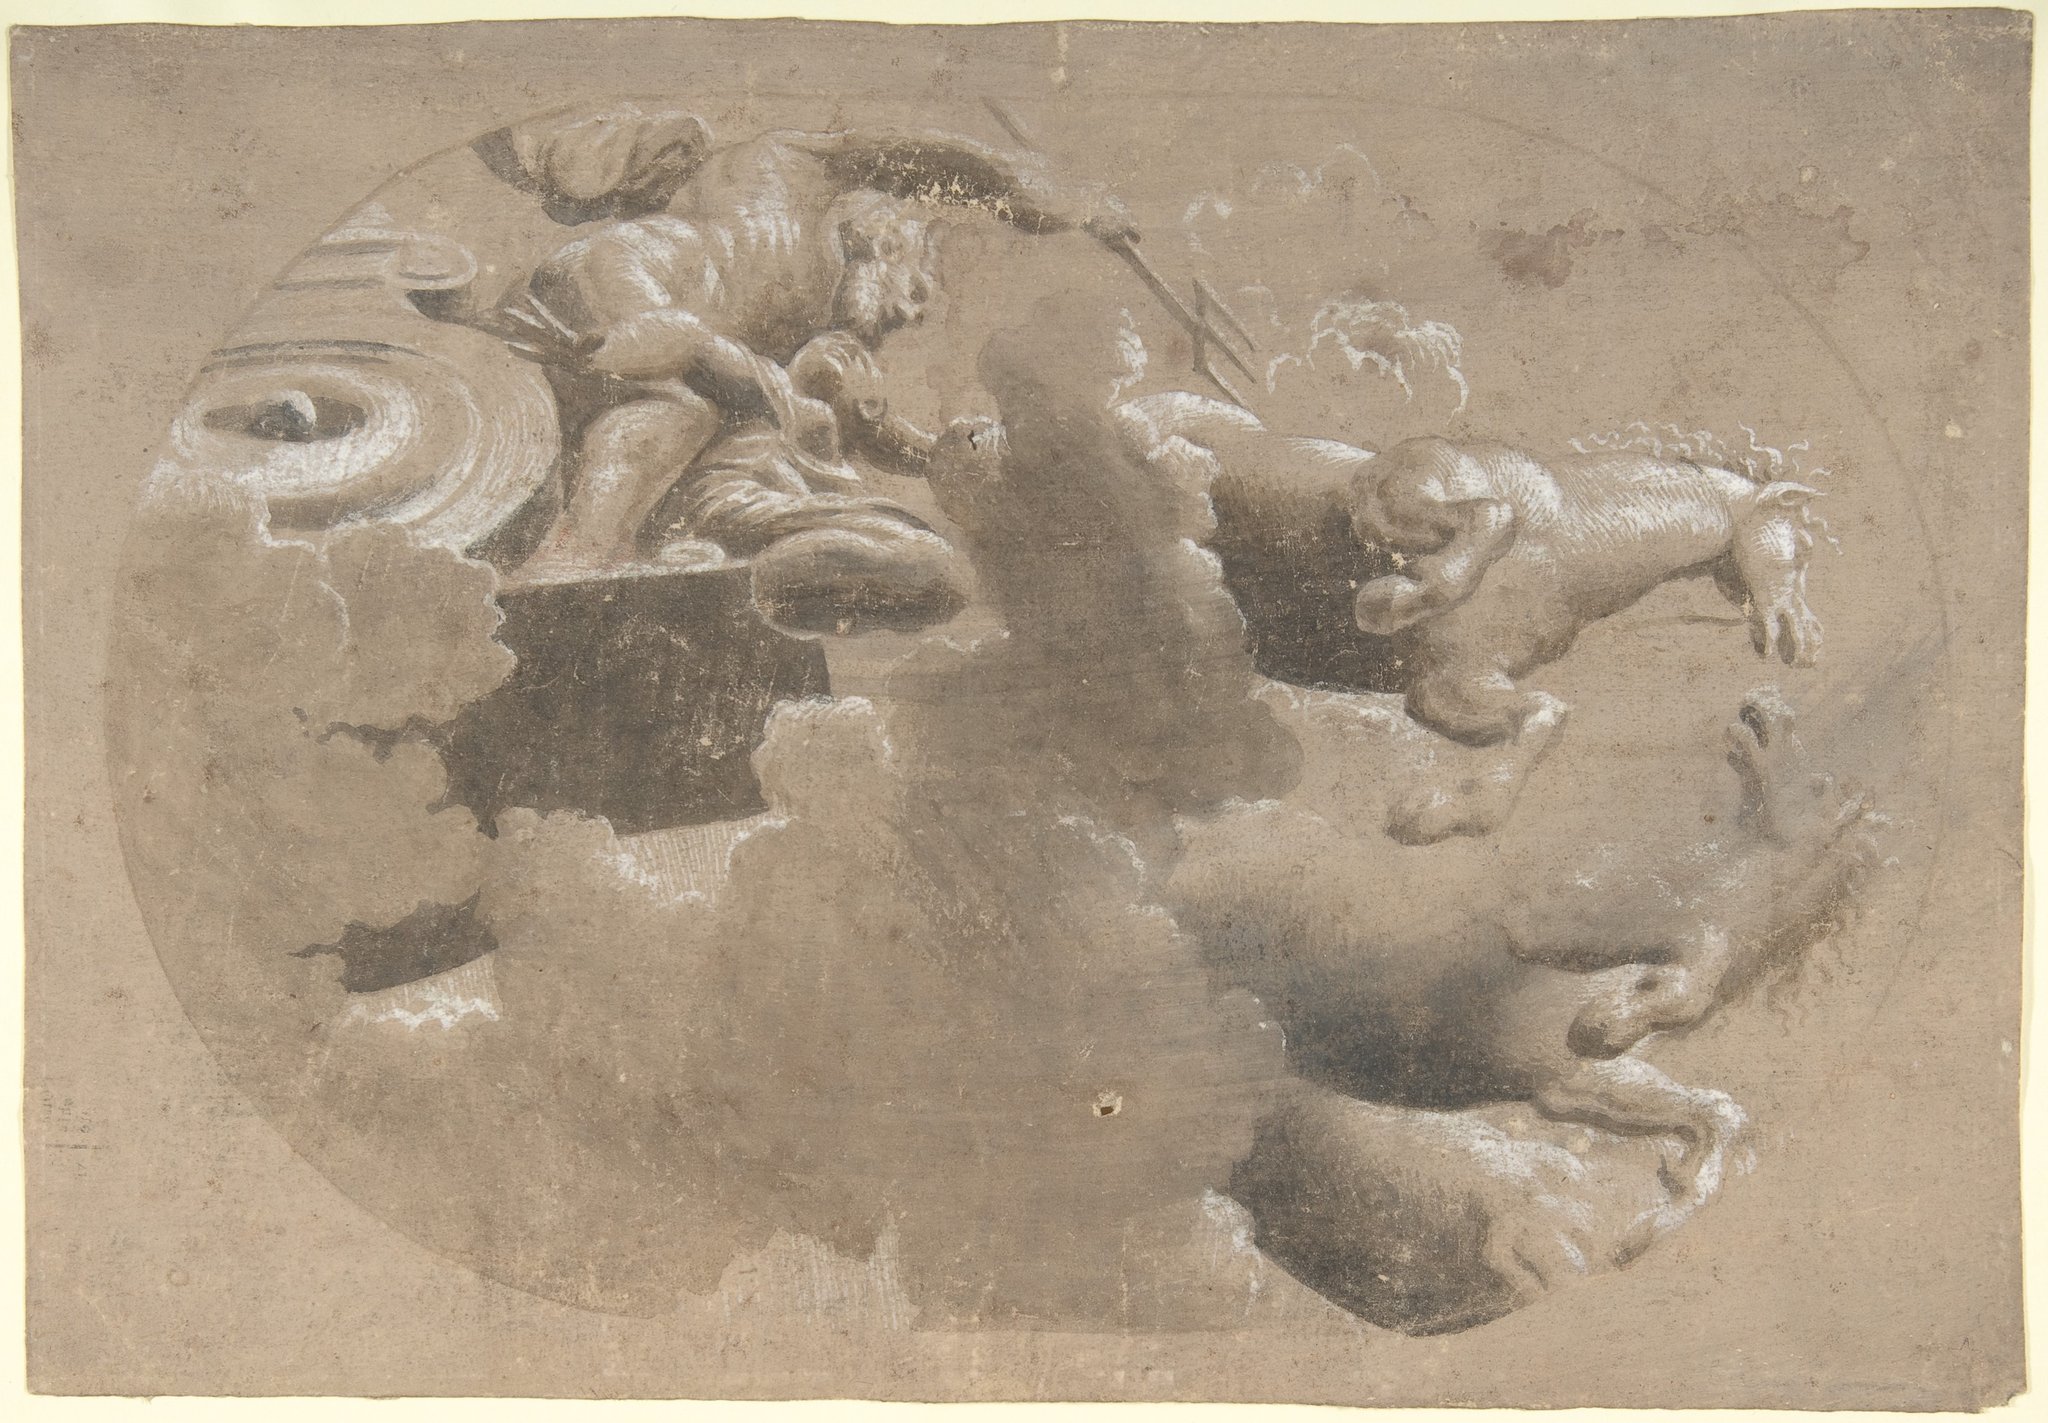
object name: drawing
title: Design for a Ceiling: Male Figure with a Trident and Another Figure in a Horse Drawn Chariot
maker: anonymous, italian, 16th century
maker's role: artist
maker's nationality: italian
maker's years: 1550-1600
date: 1501-1600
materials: paper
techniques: brush, highlighting, wash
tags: men,horses,chariots